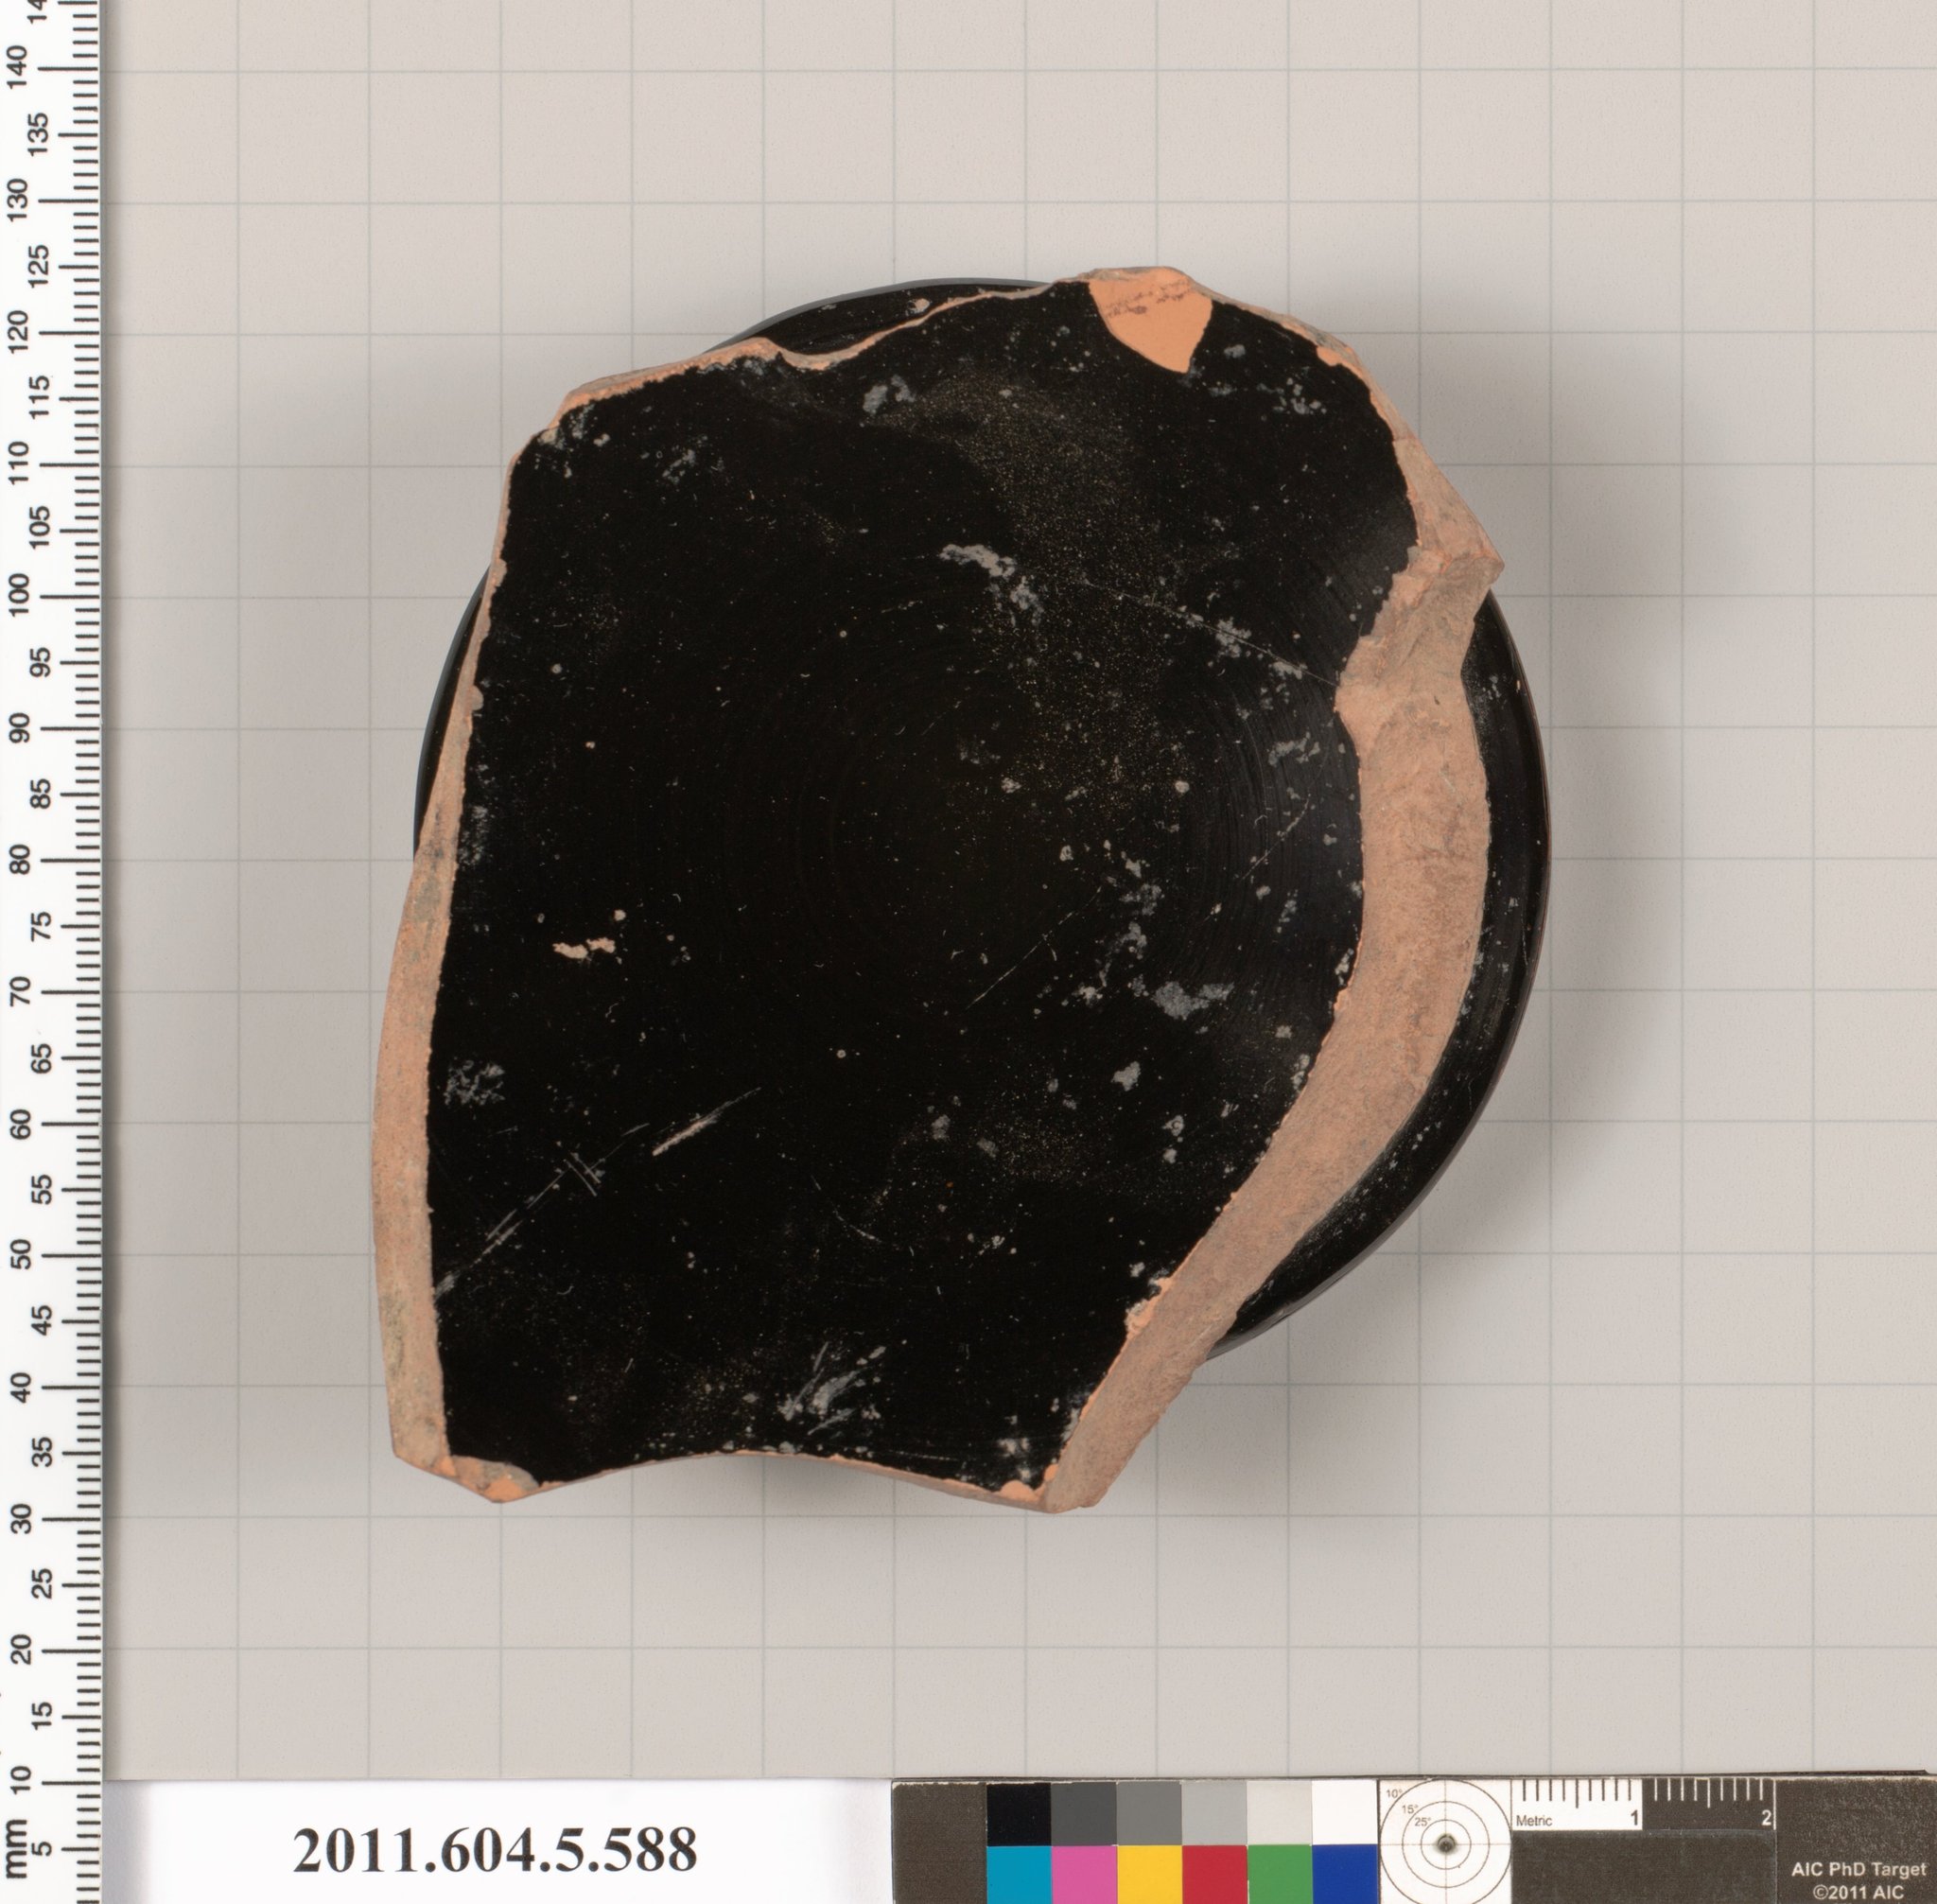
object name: stemless kylix fragment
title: Terracotta fragment of a stemless kylix (drinking cup)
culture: greek, attic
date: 600-401 BCE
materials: terracotta